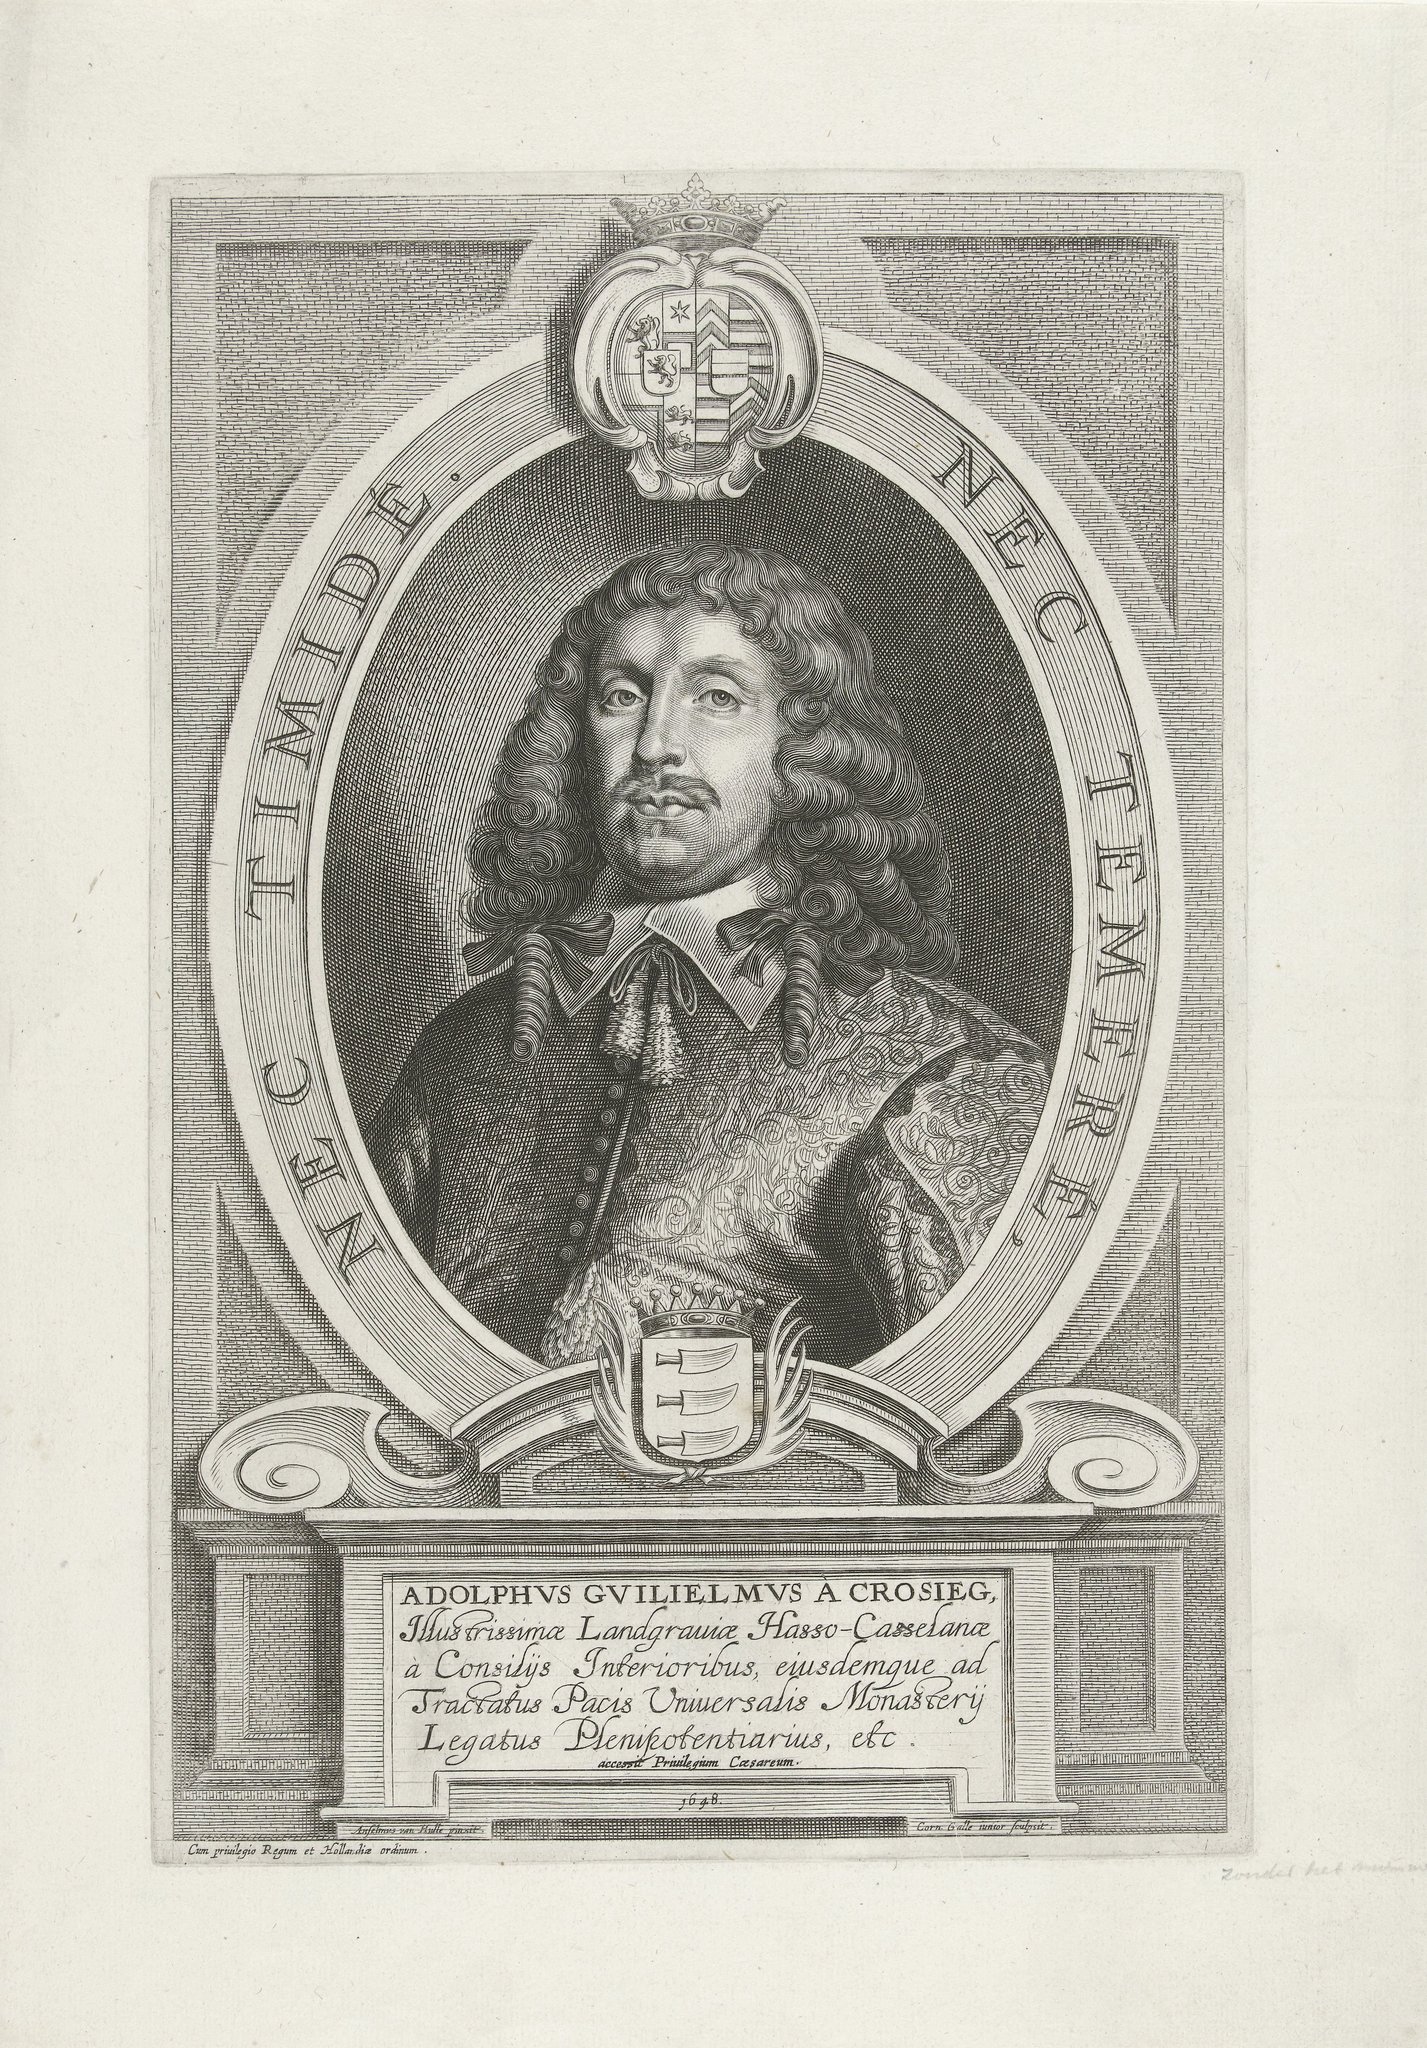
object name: print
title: Portret van Adolf Wilhelm van Krosigk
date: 1648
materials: paper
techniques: engraving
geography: antwerp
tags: adolf wilhelm von krosigk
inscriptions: collector's mark: Lugt 2228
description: Portret van Adolf Wilhelm van Krosigk, afgezant van Hessen-Cassel tijdens de onderhandelingen voor de Vrede van Münster, in ovaal met randschrift en wapens.